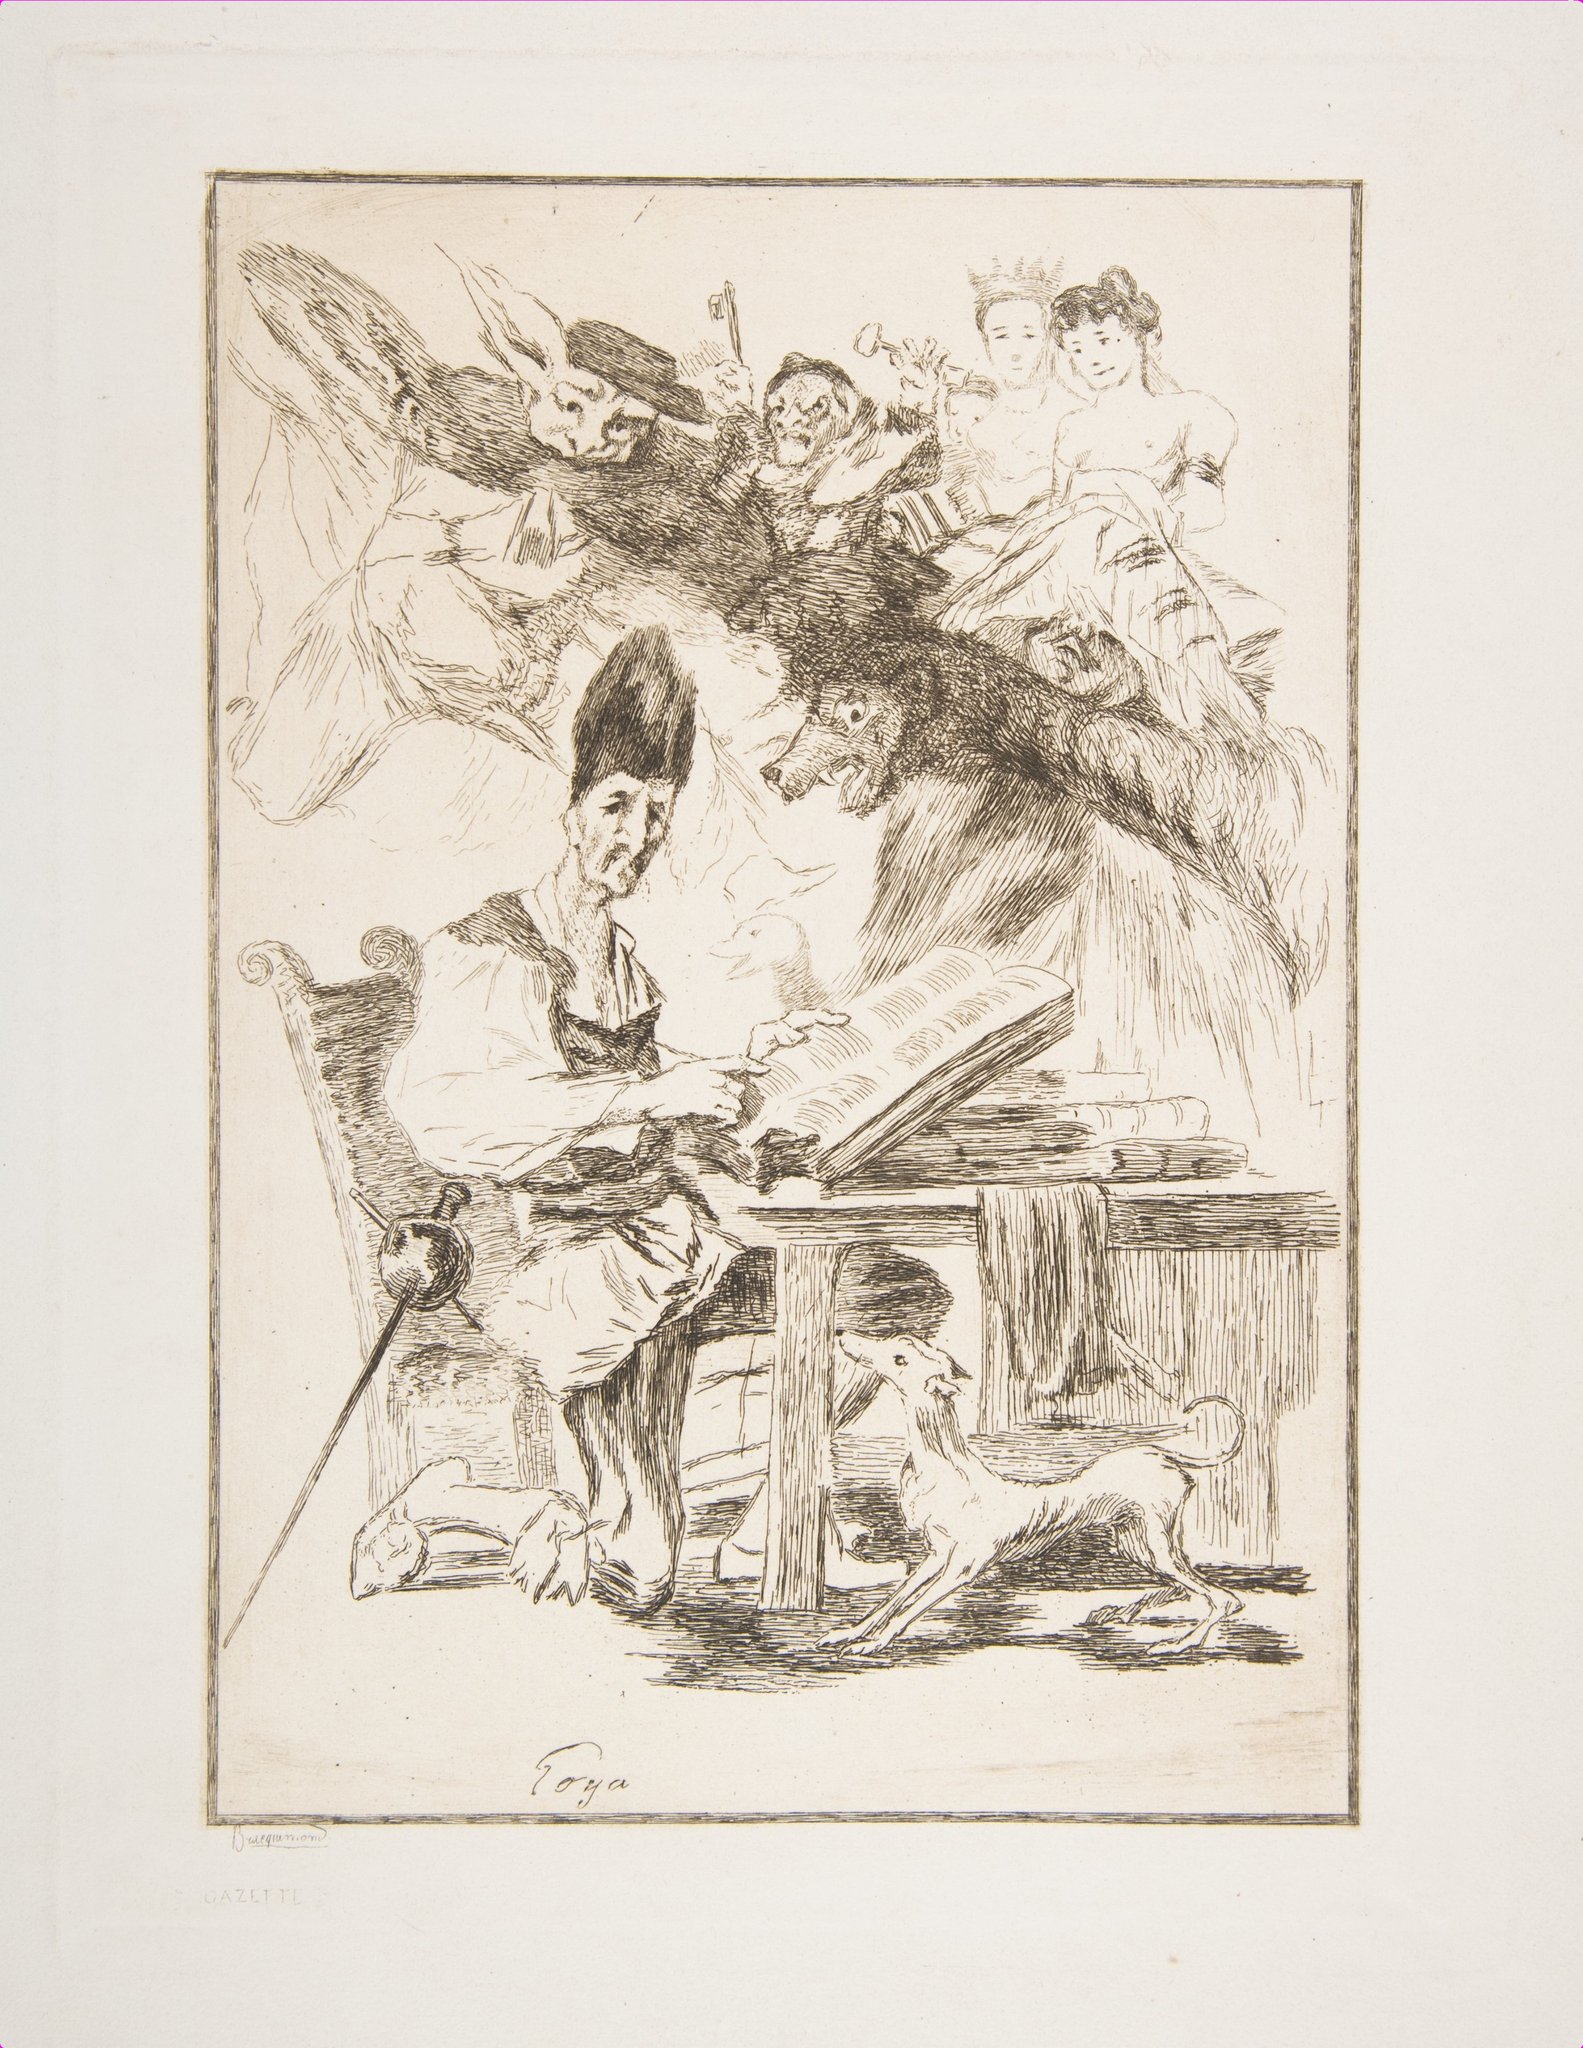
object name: print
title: Don Quichotte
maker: félix bracquemond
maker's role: artist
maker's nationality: french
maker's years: 1833-1914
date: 1860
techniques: etching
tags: bears,men,women,dogs,don quixote